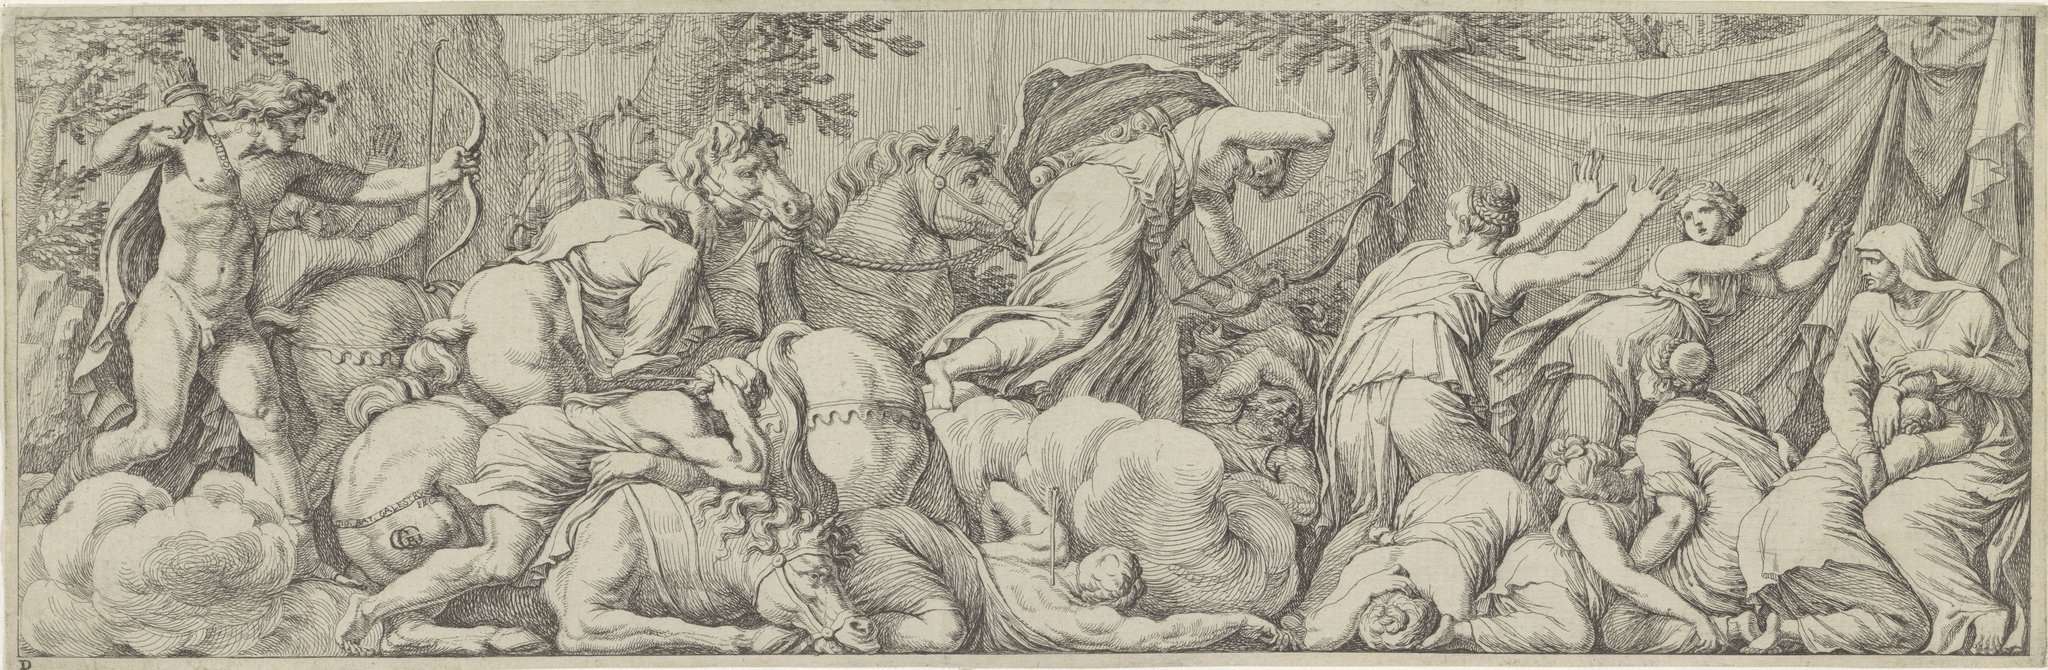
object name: print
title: Apollo en Diana doden de kinderen van Niobe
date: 1625-1669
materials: paper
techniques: etching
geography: italy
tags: apollo and diana kill niobe's children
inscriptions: collector's mark: Lugt 2228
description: Apollo en Diana, beiden met pijl en boog, doden de kinderen van Niobe. Verschillende kinderen liggen dood op de grond, anderen proberen te vluchten. Niobe zit rechts. Ondemarge links: D.